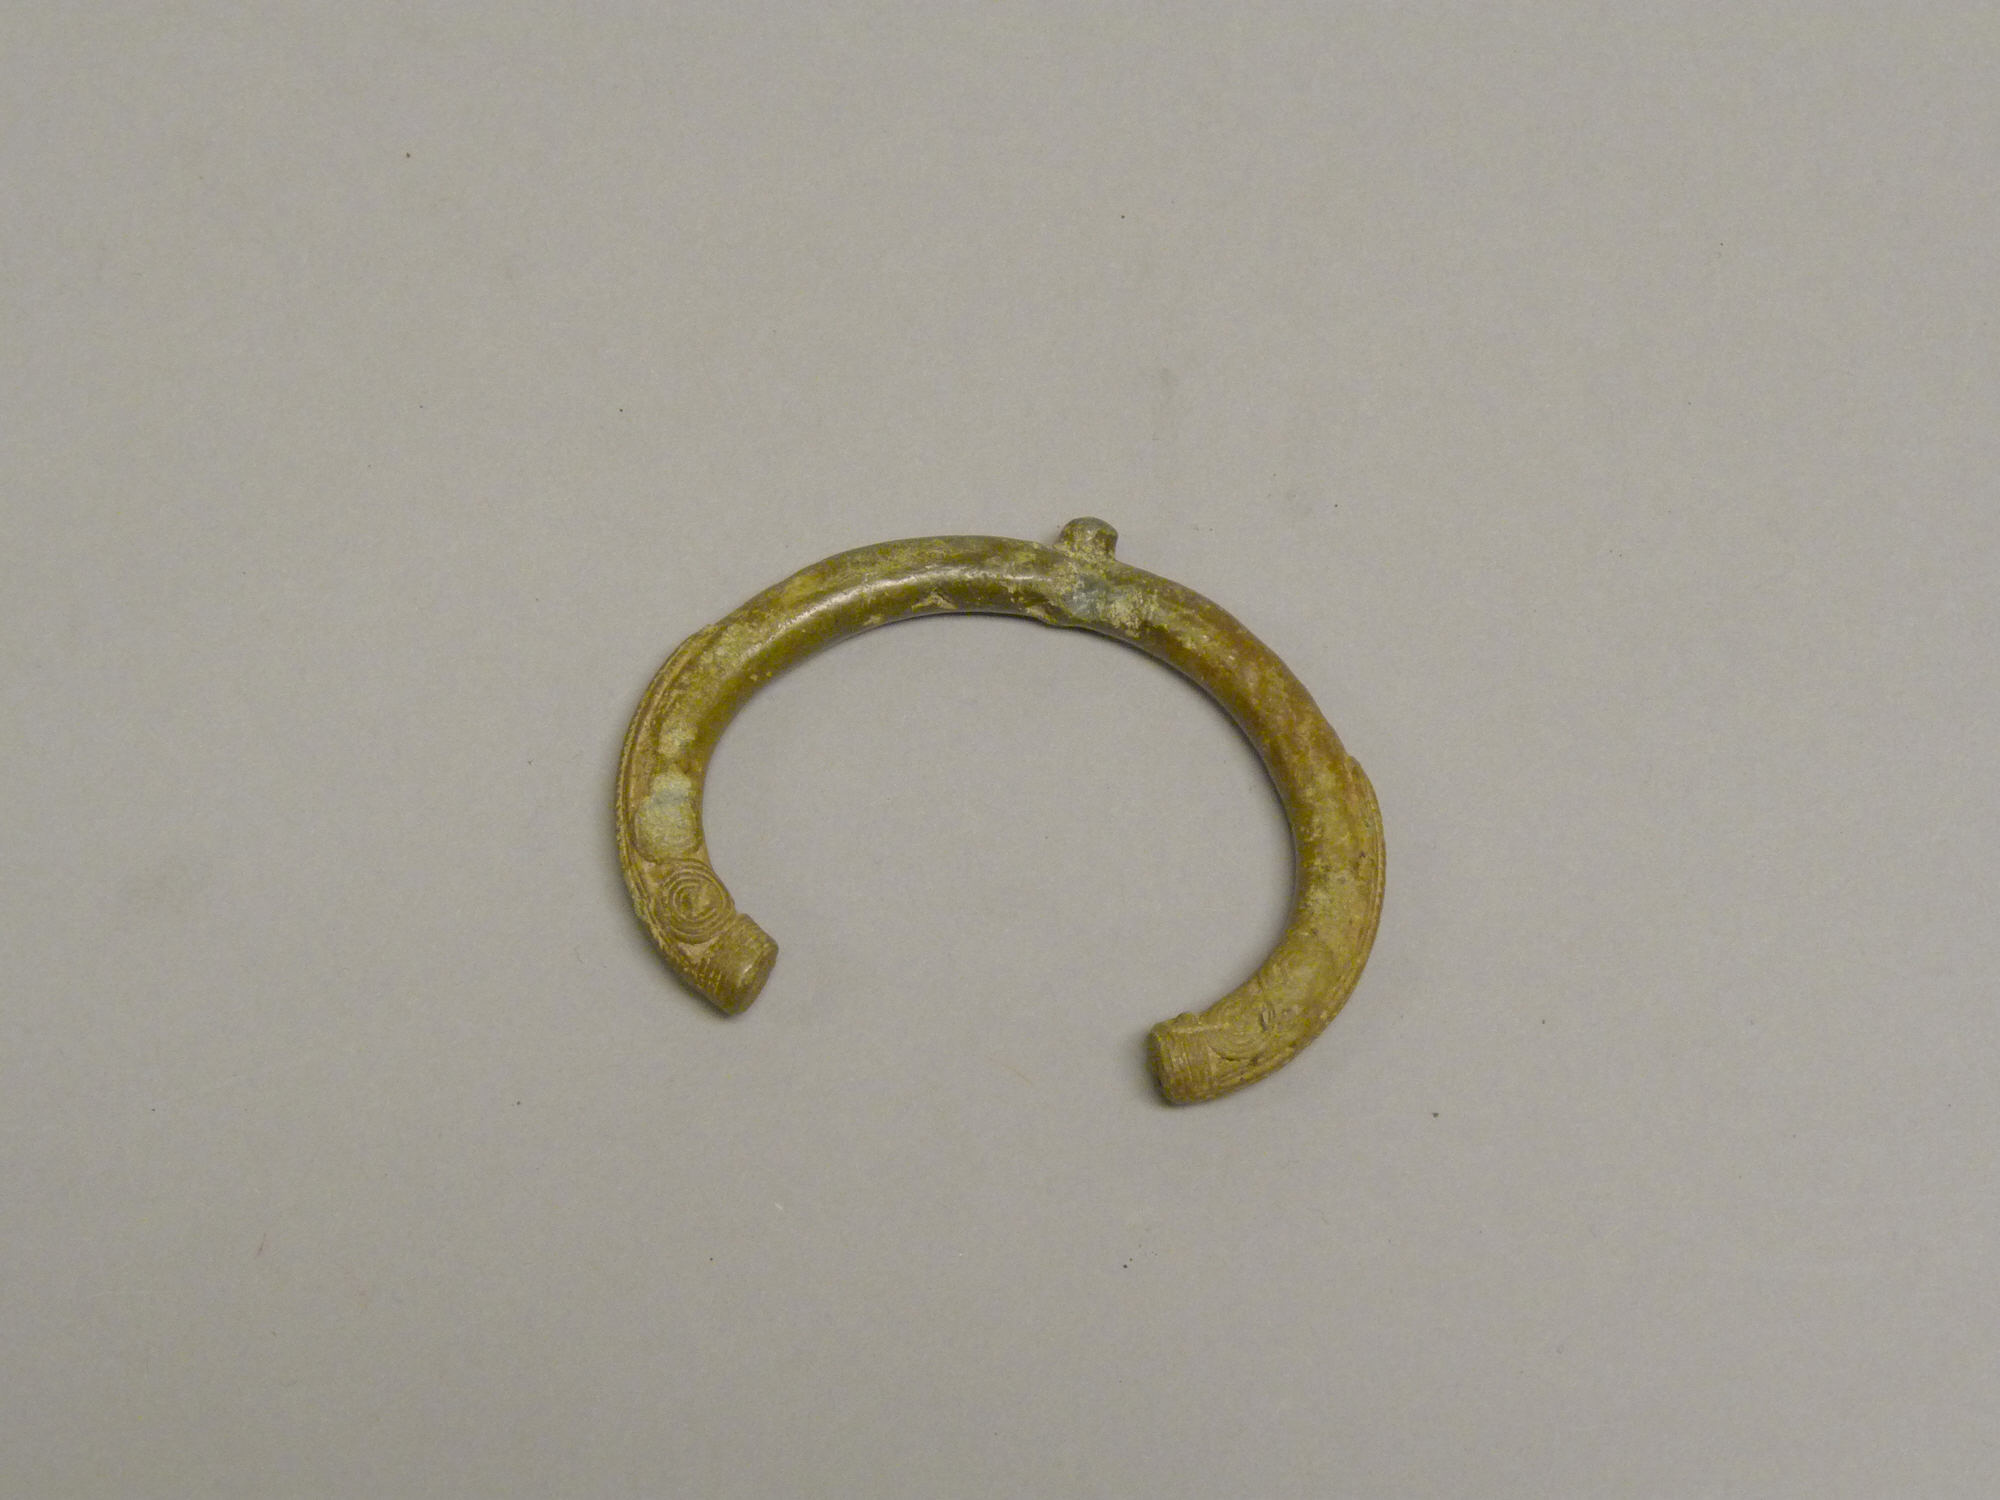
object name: bangle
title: Open Bangle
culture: thai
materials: bronze